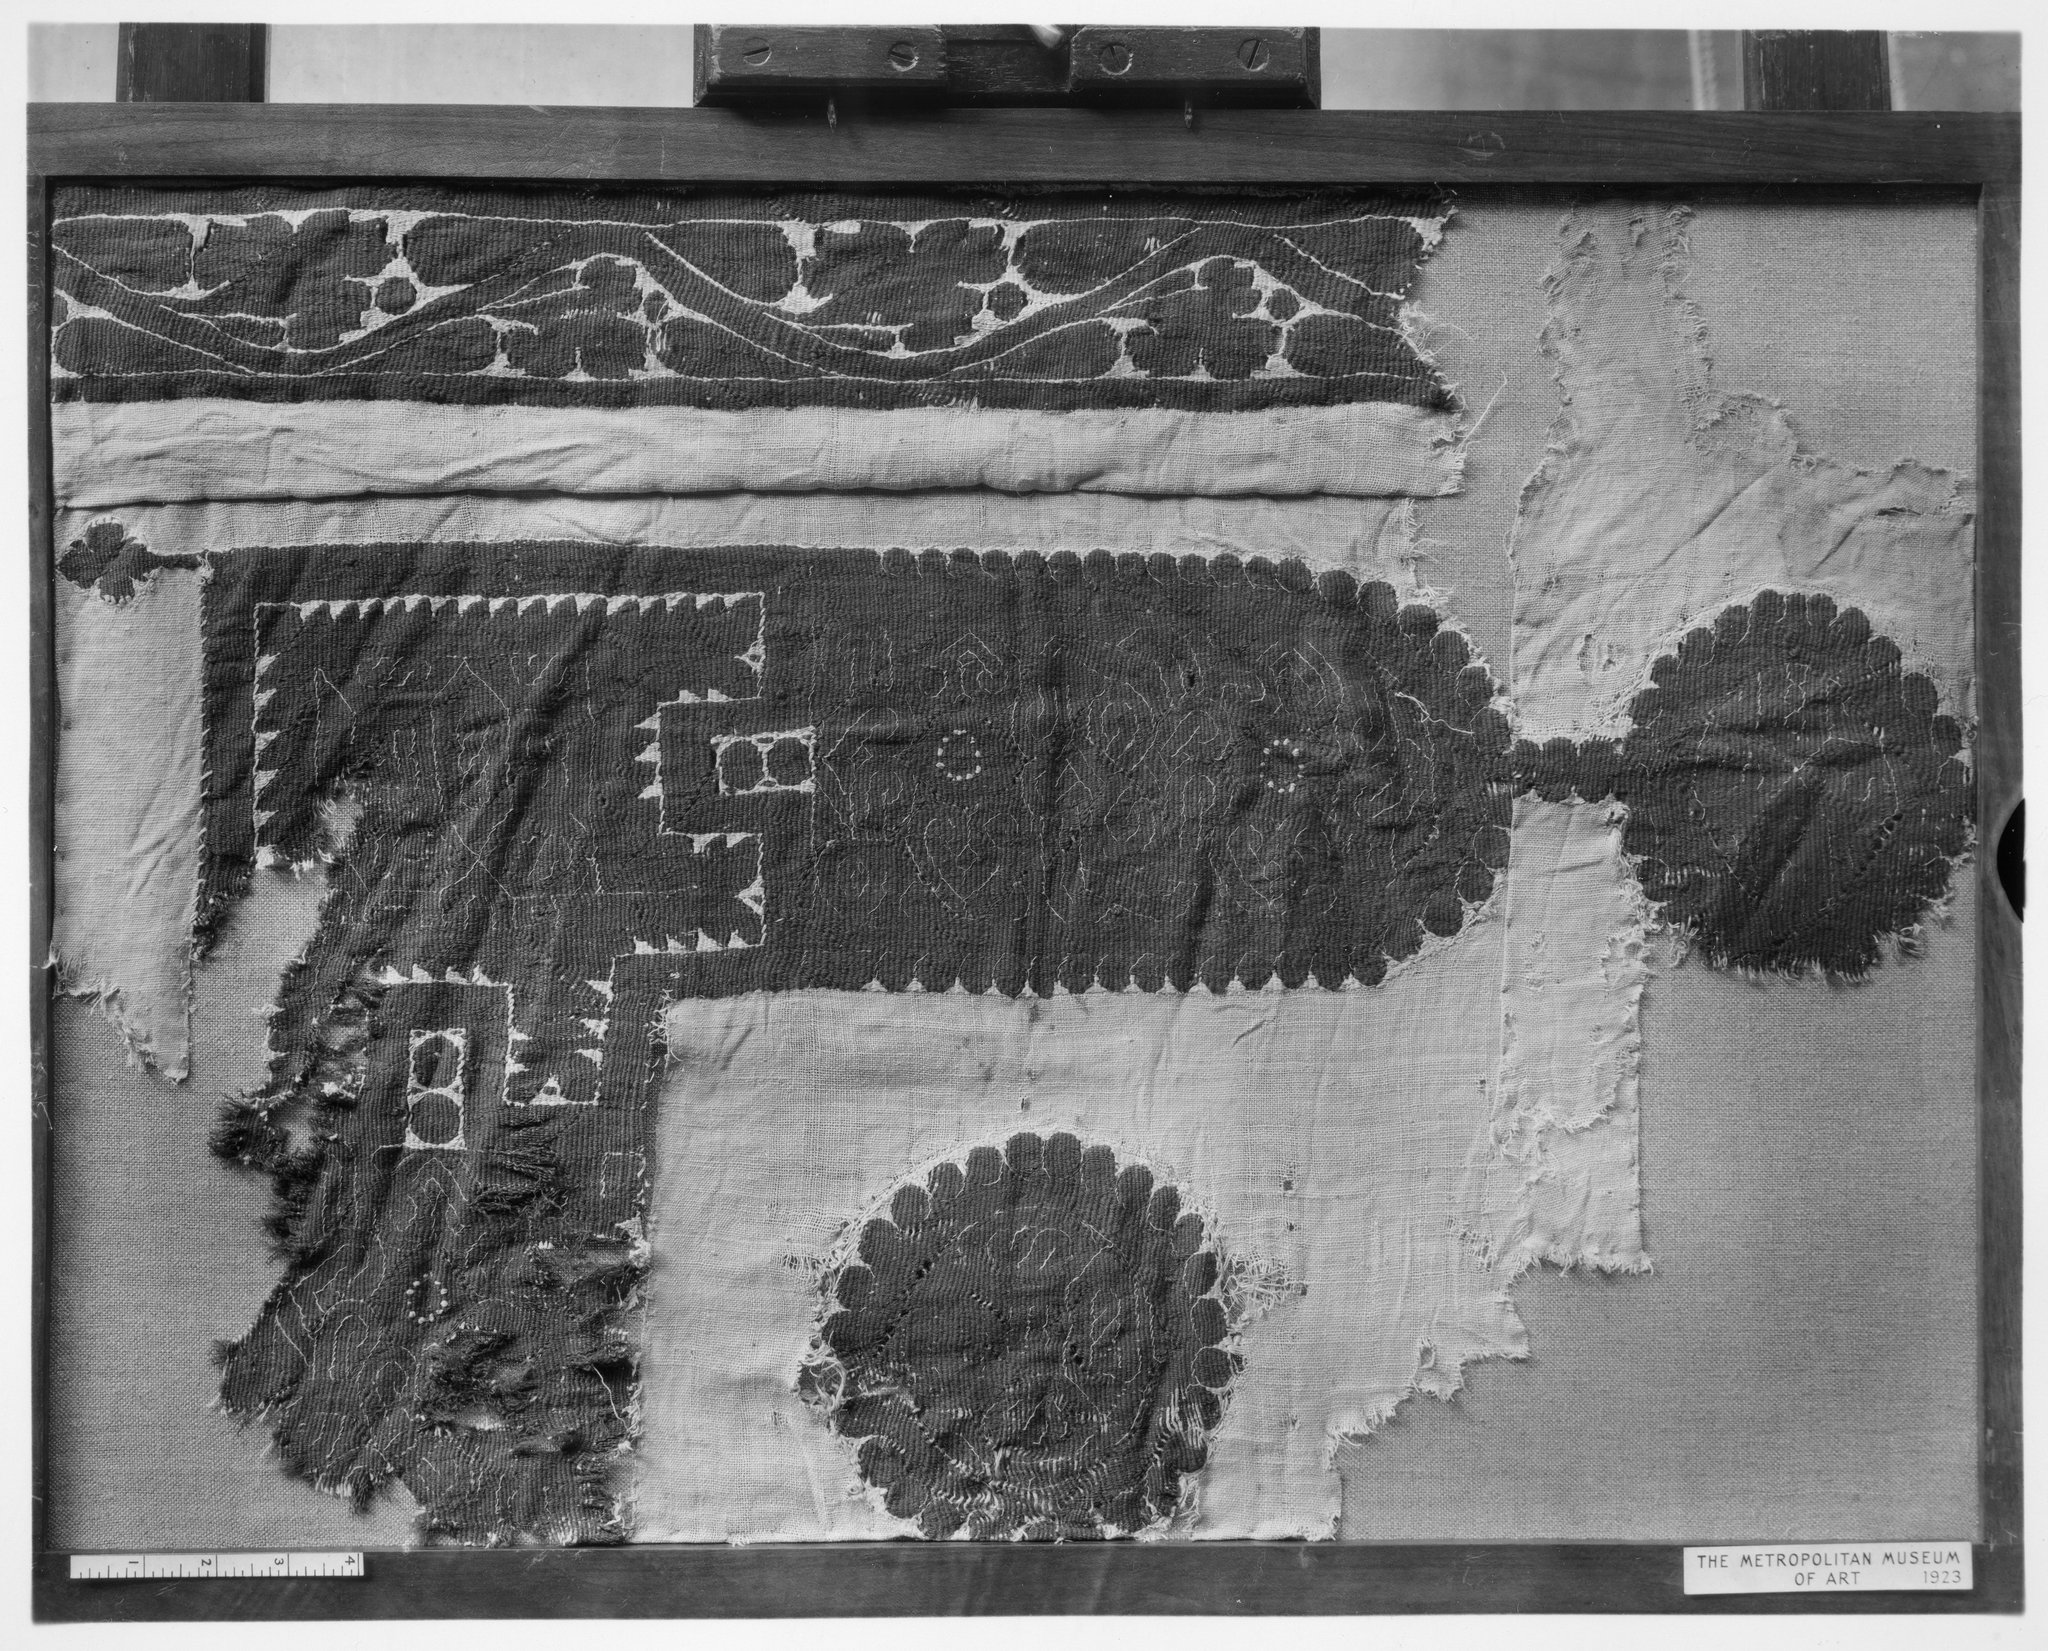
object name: textile fragment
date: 201-400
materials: linen, wool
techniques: weave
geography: egypt